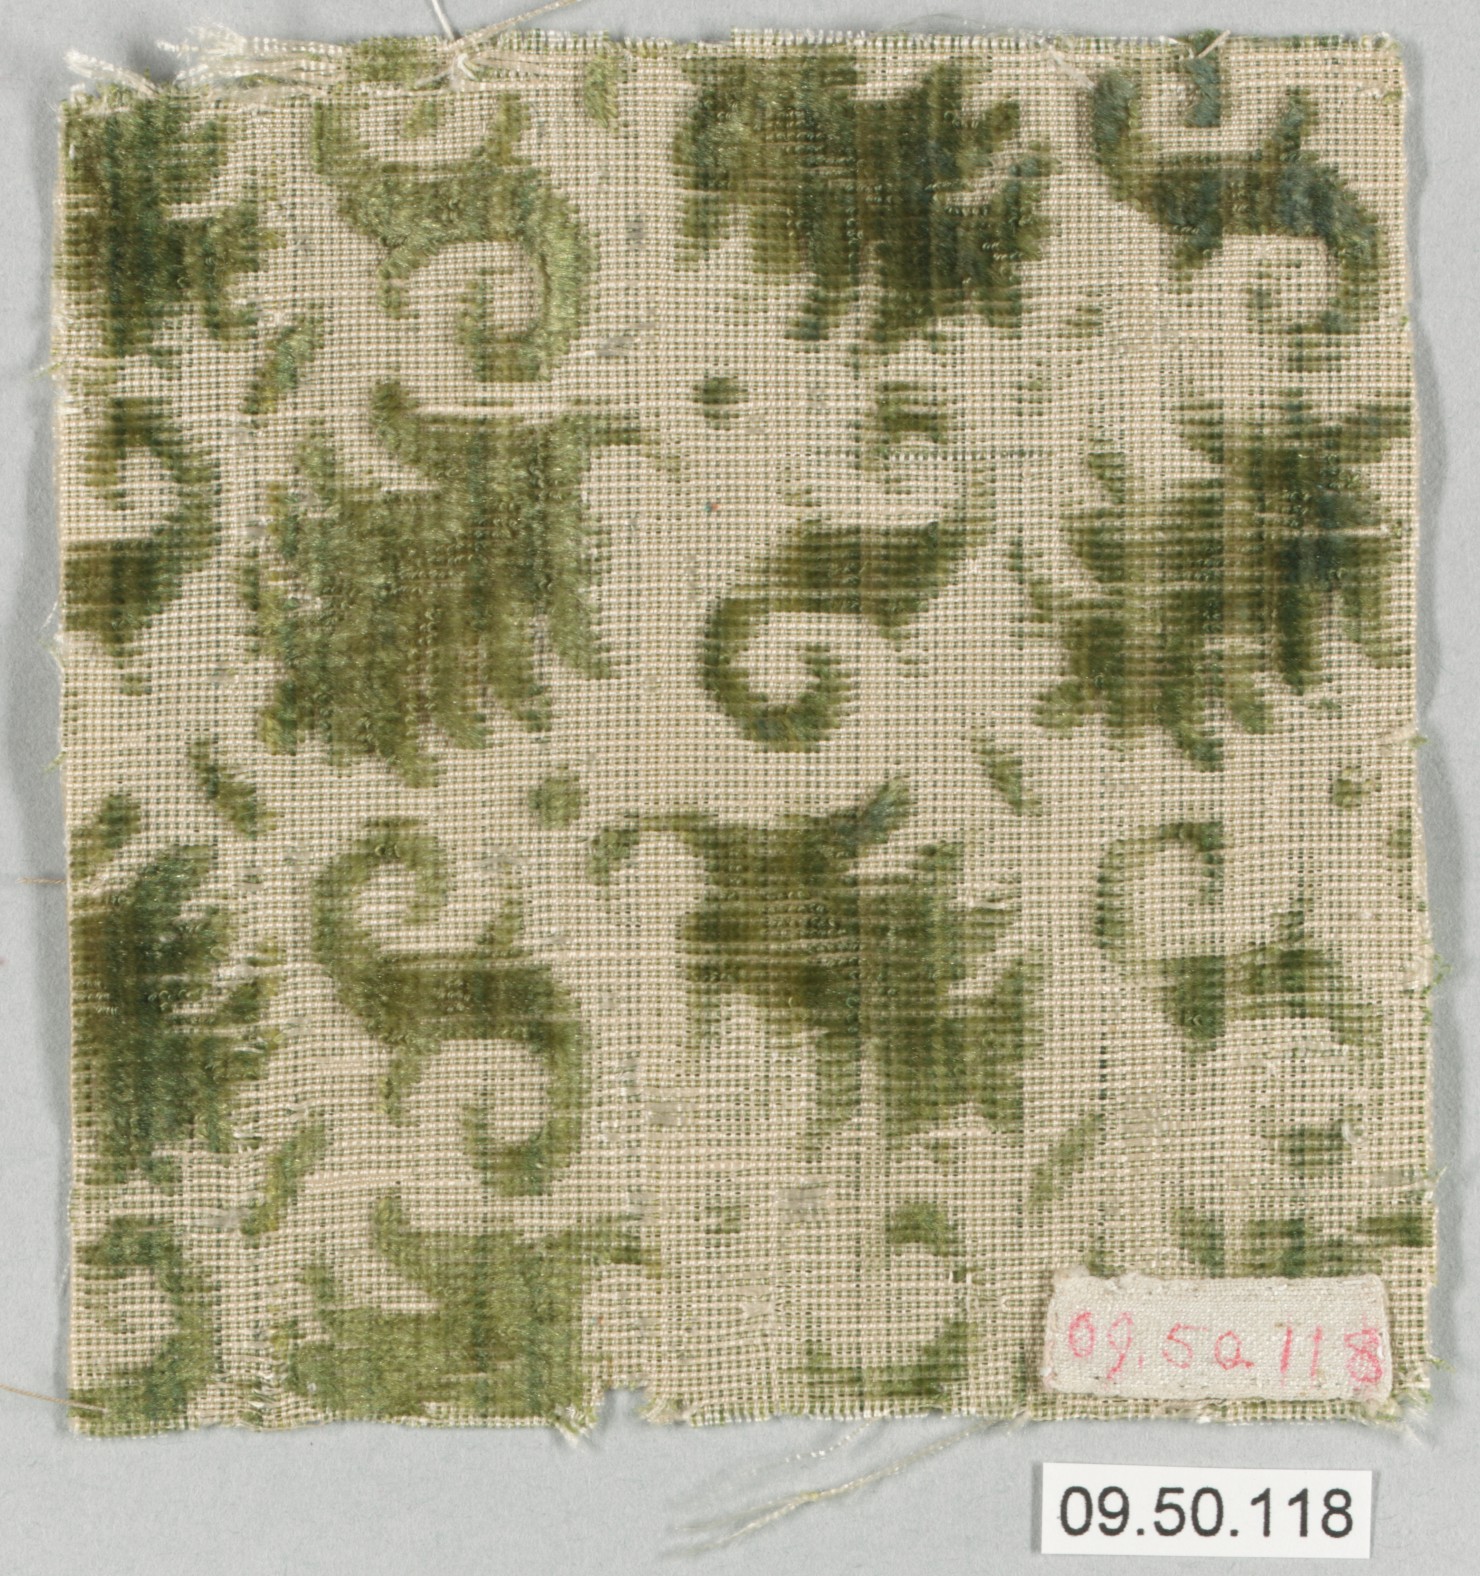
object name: piece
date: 1501-1700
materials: silk